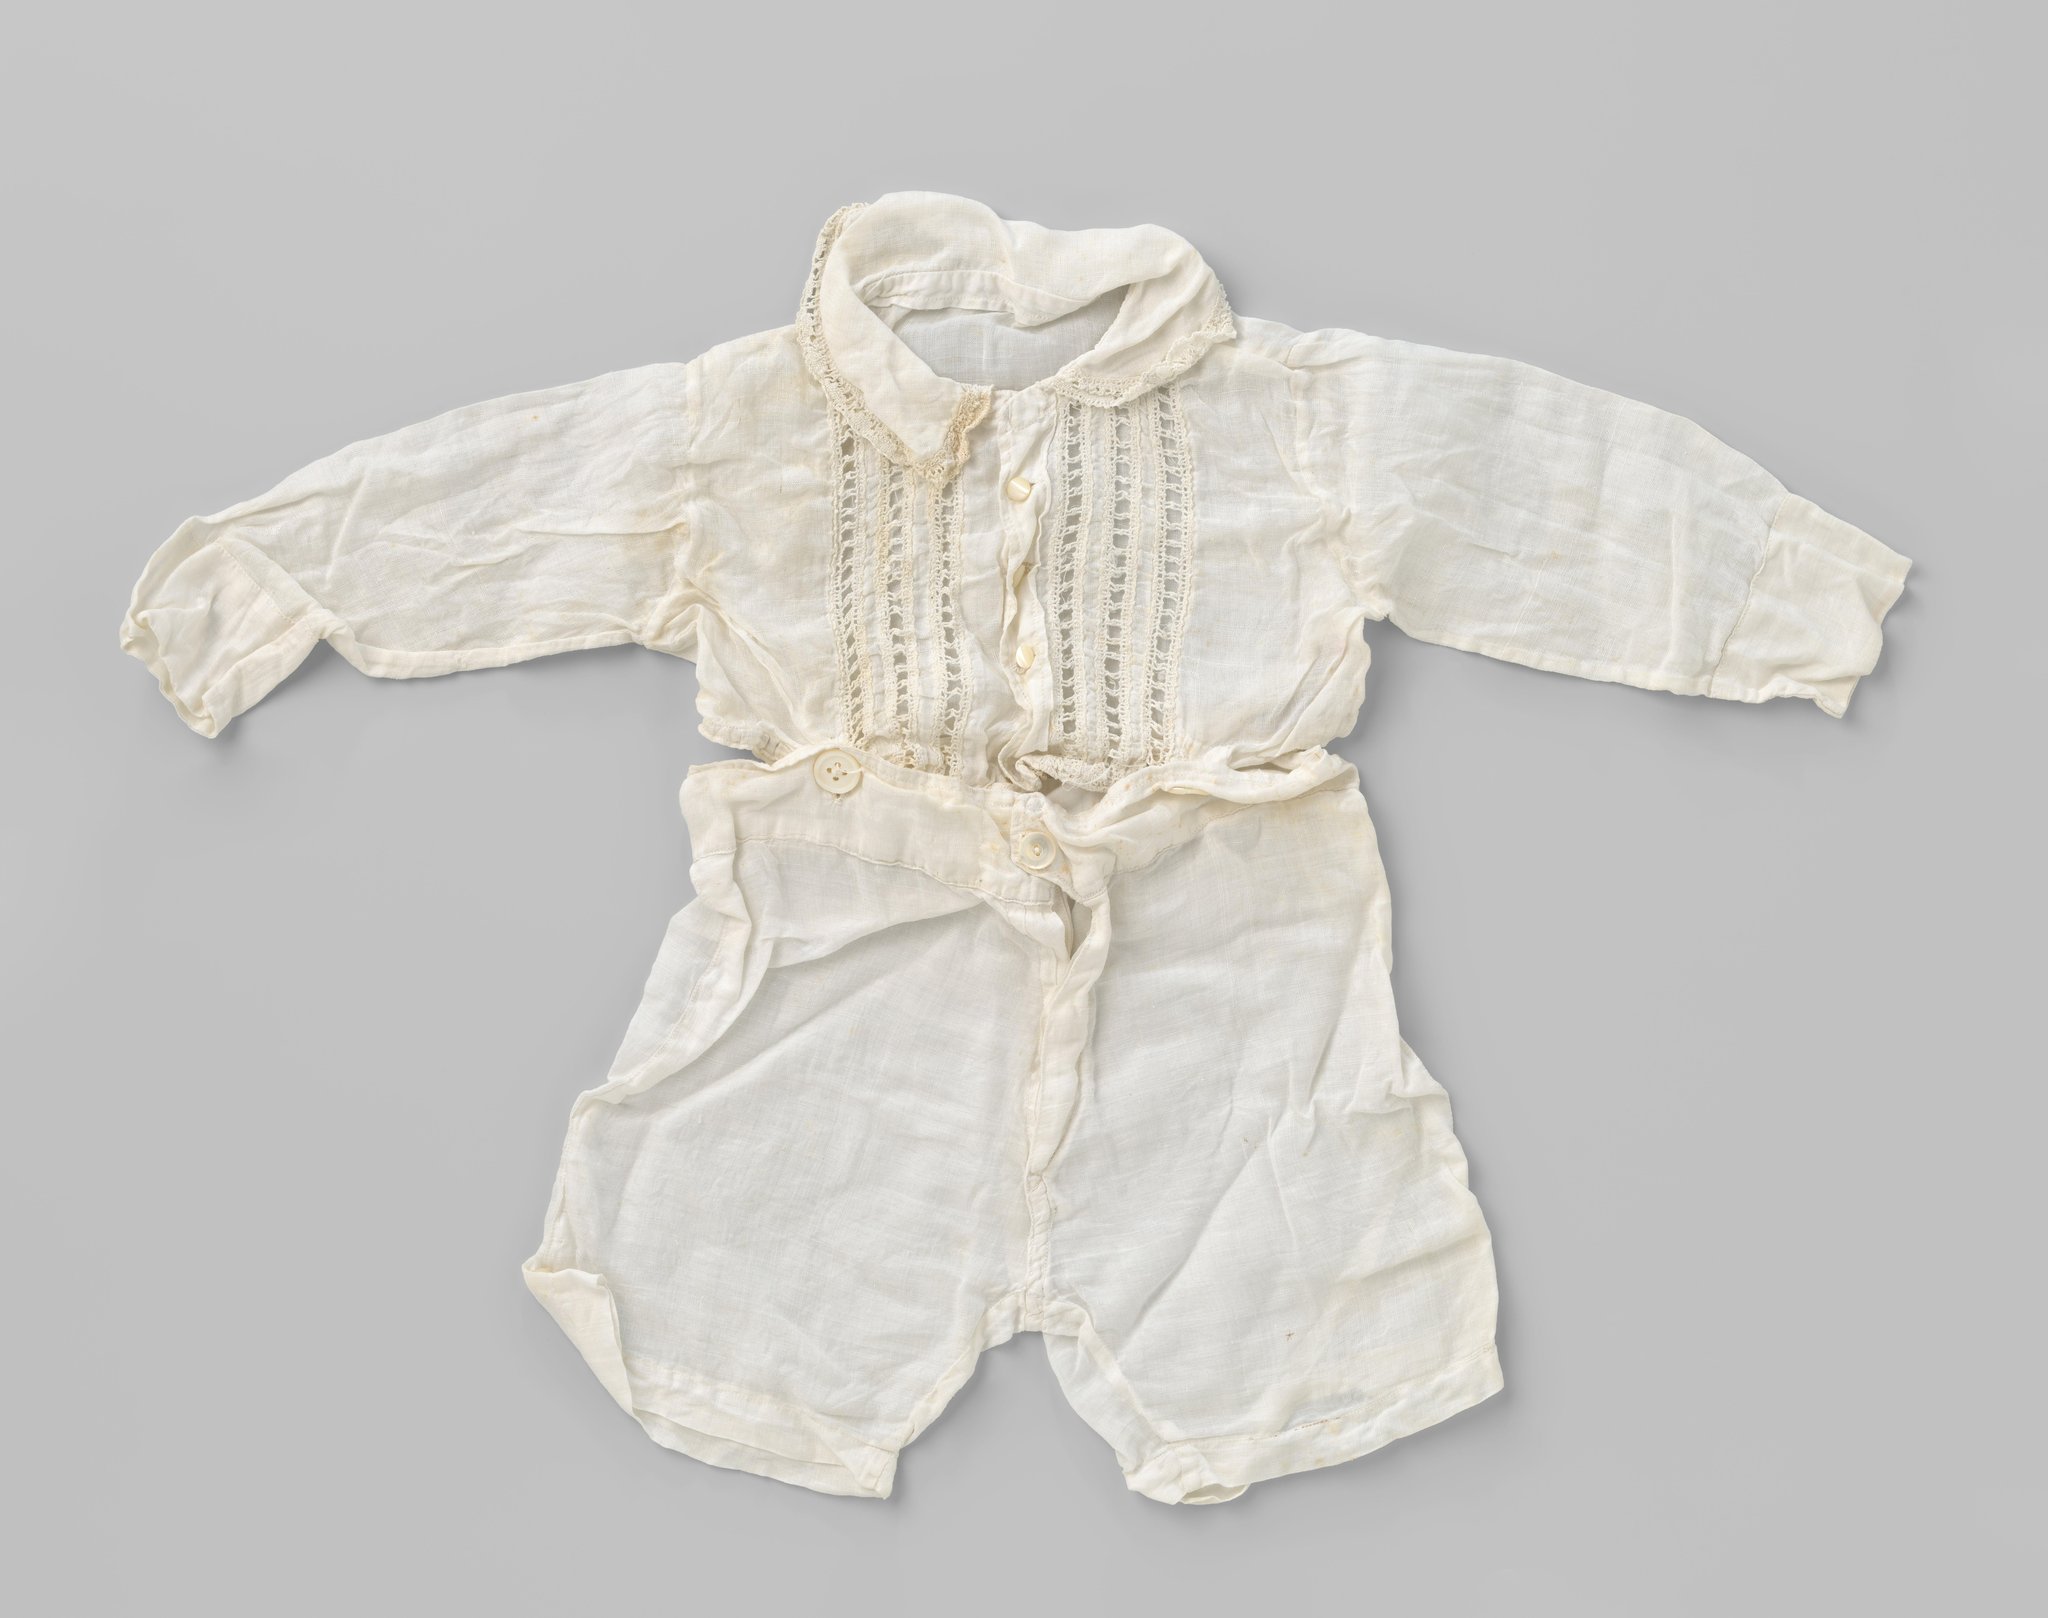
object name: childrenswear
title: Wit pak met bovenstuk met lange mouwen vastgeknoopt aan korte broek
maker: Anonymous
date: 1900-1950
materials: textile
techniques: knitting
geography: europe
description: Op de voorzijde van het bovenstuk zitten aan weerszijden van een rij ronde witte parelmoerkleurige knopen drie tussenzetsels.